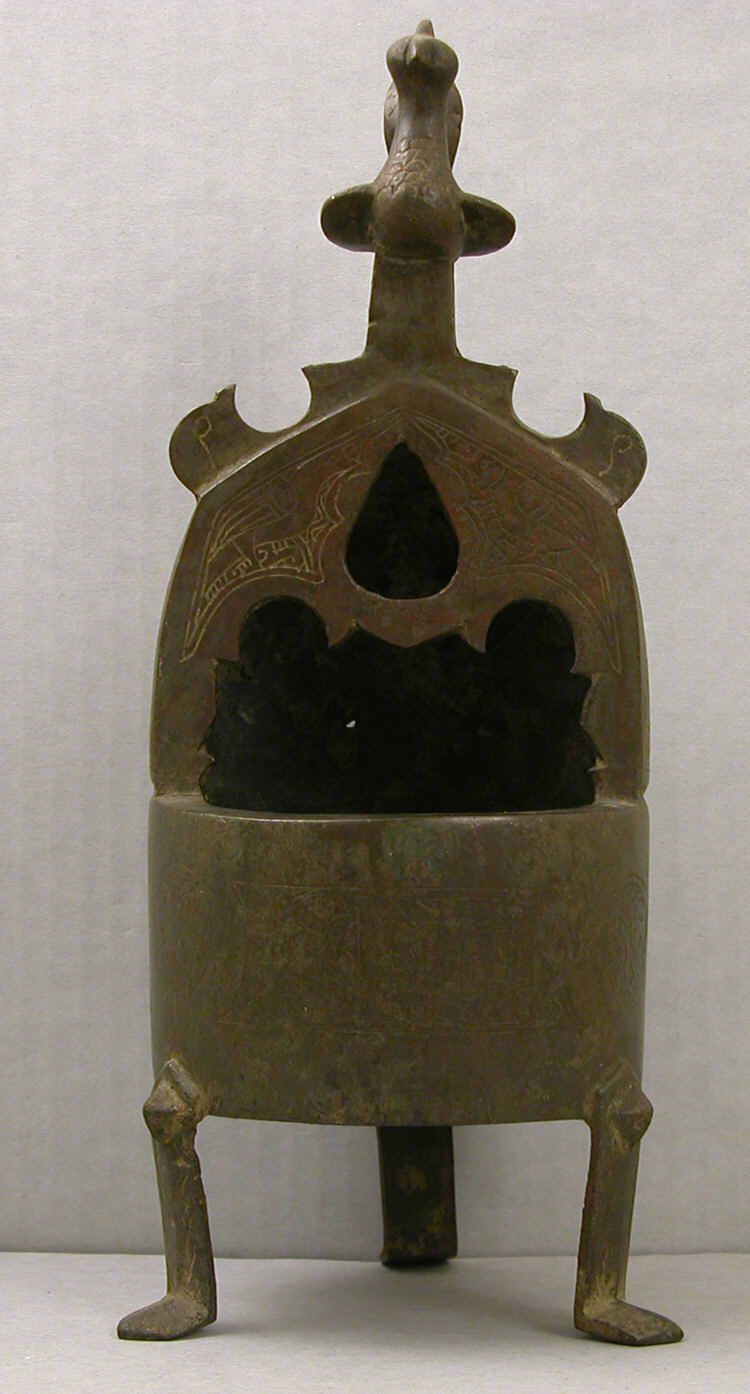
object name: incense burner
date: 1101-1200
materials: bronze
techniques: engraving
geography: iran